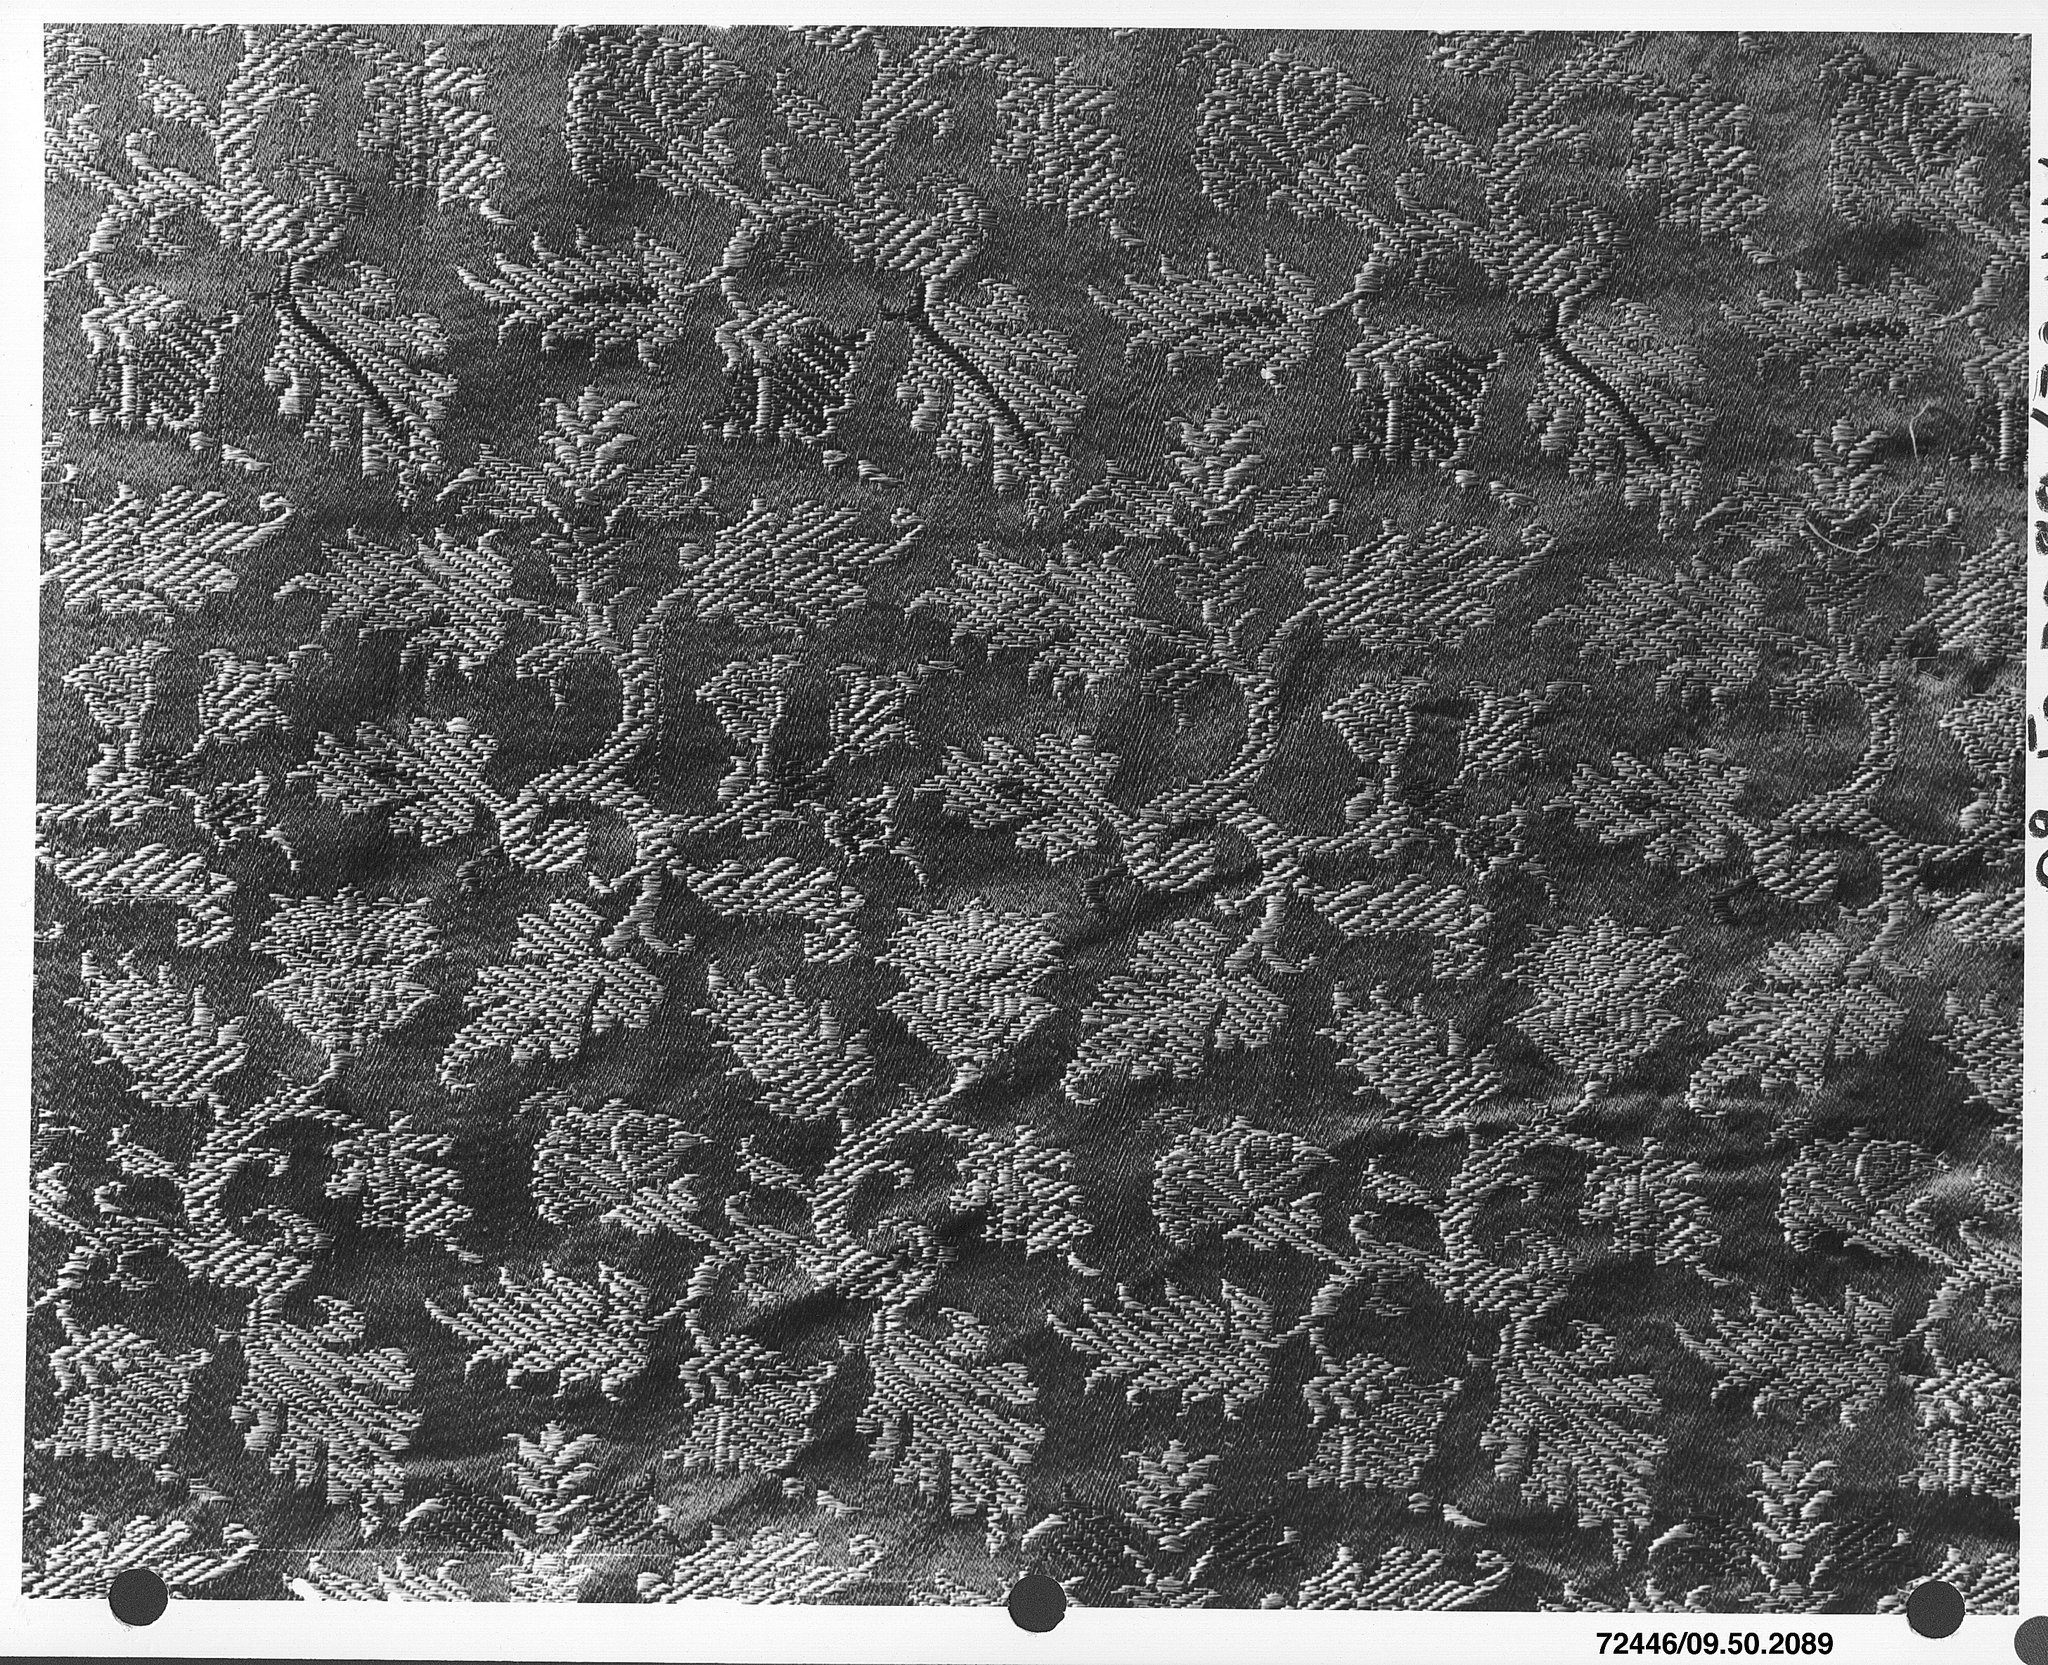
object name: piece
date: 1601-1800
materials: silk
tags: leaves